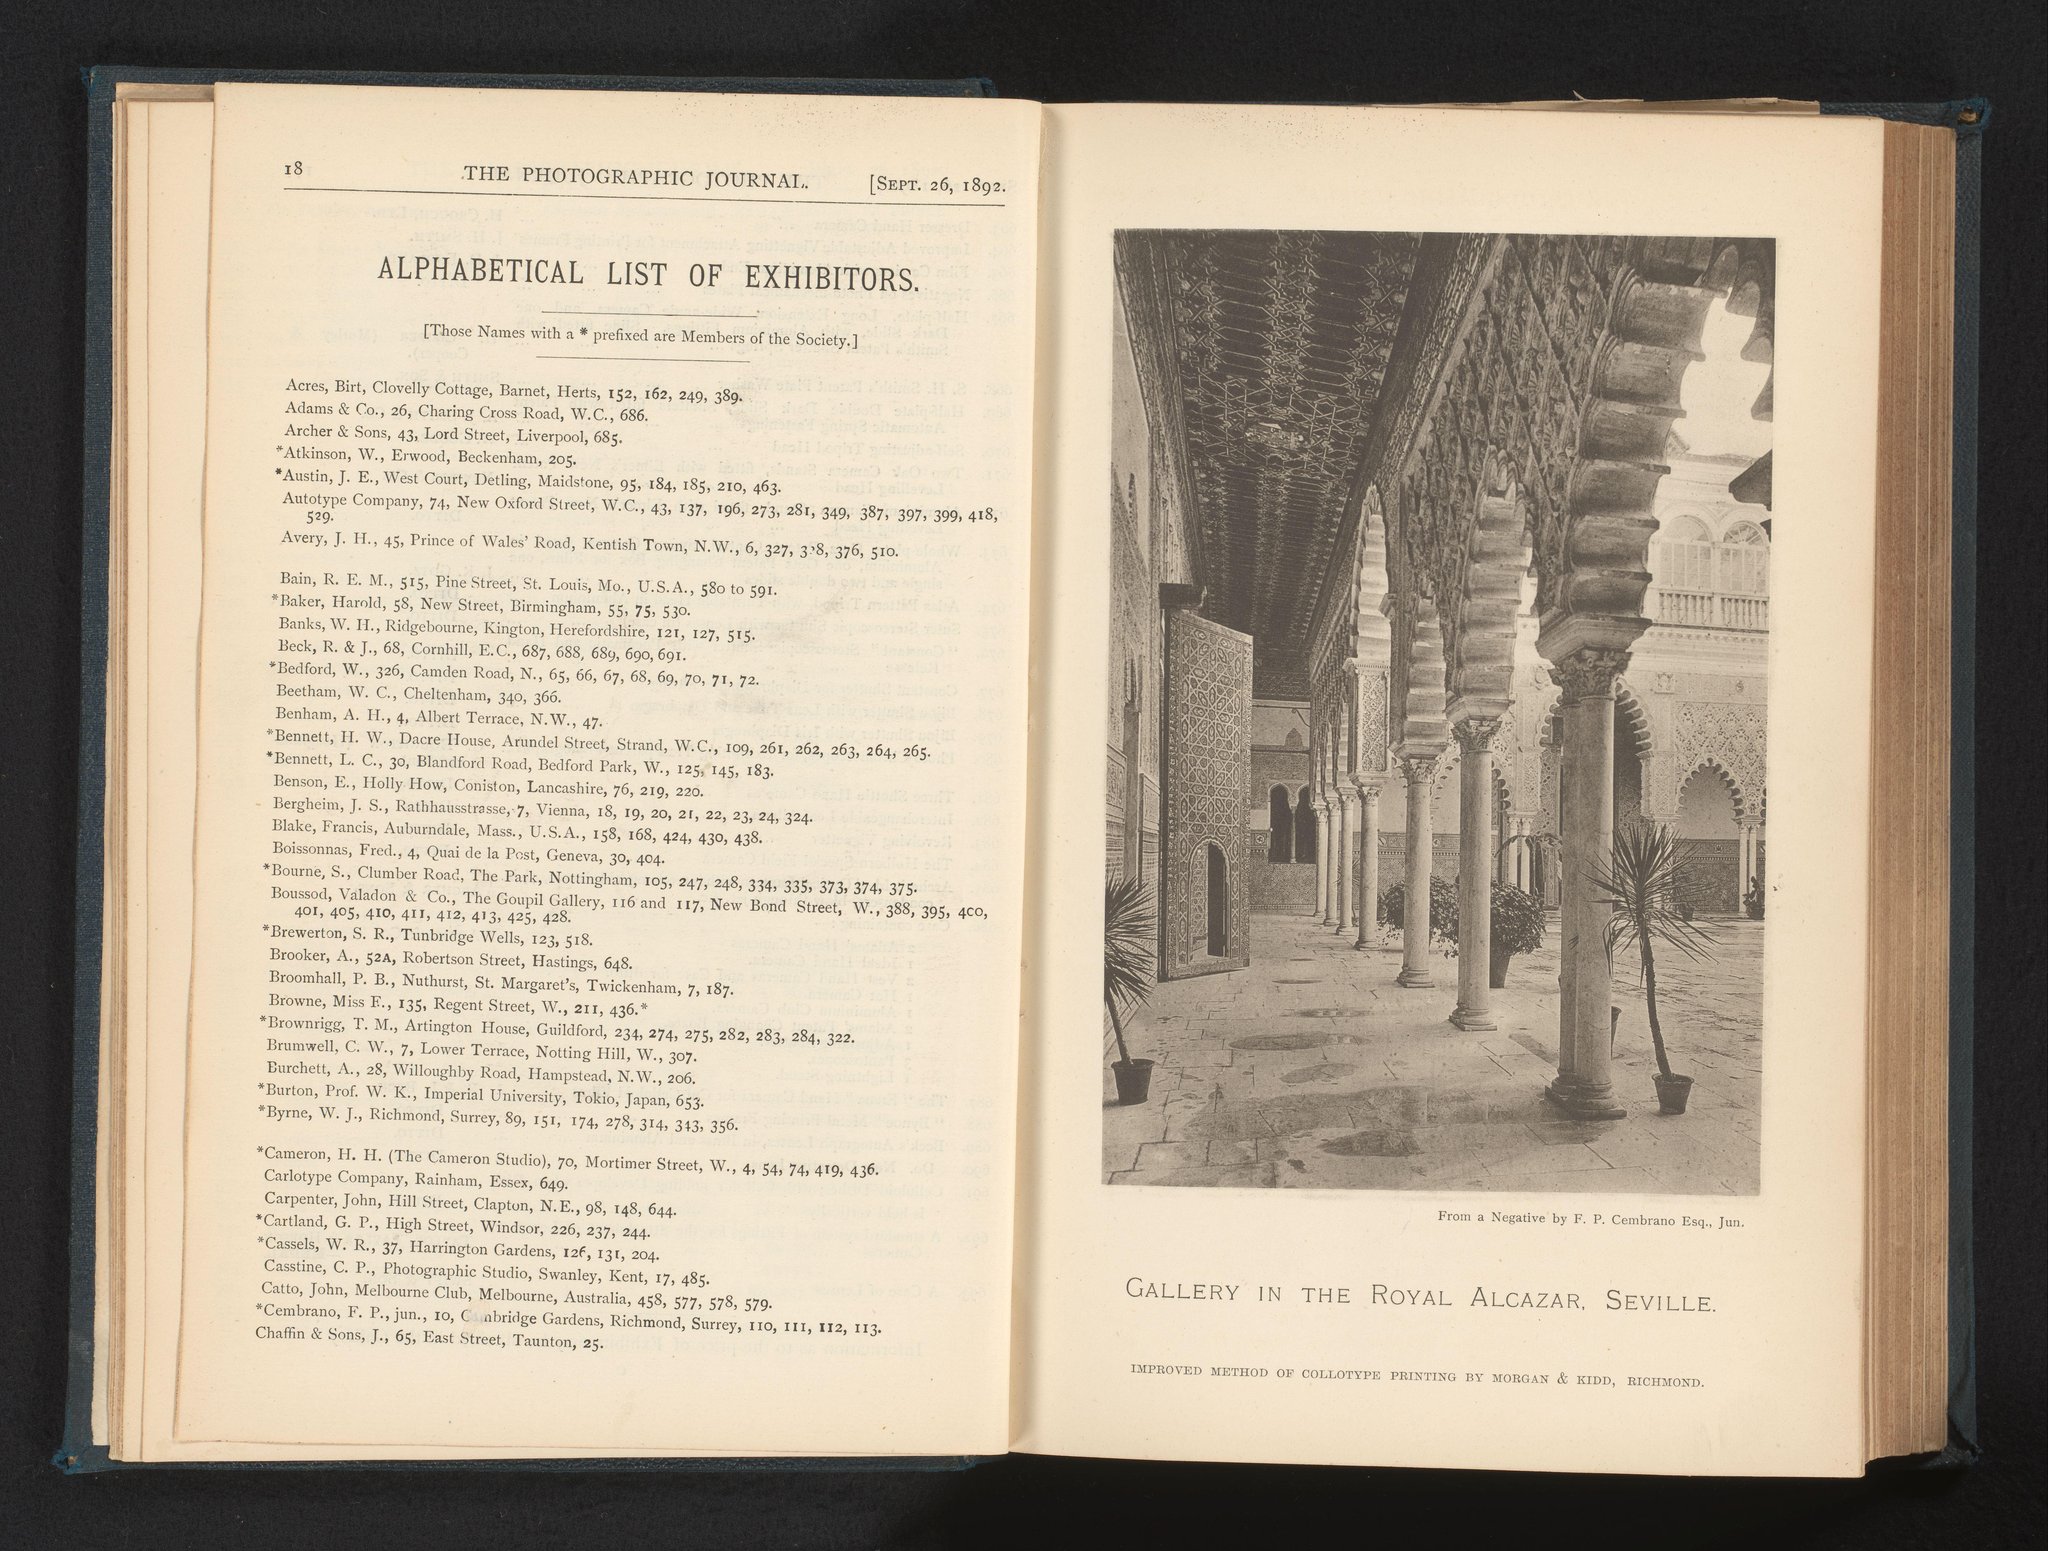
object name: photomechanical print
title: Gallery in the Royal Alcazar, Seville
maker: f.p. cembrano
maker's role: fotograaf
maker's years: -1912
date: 1888-1893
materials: paper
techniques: photograph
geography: royal palace of seville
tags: courtyard